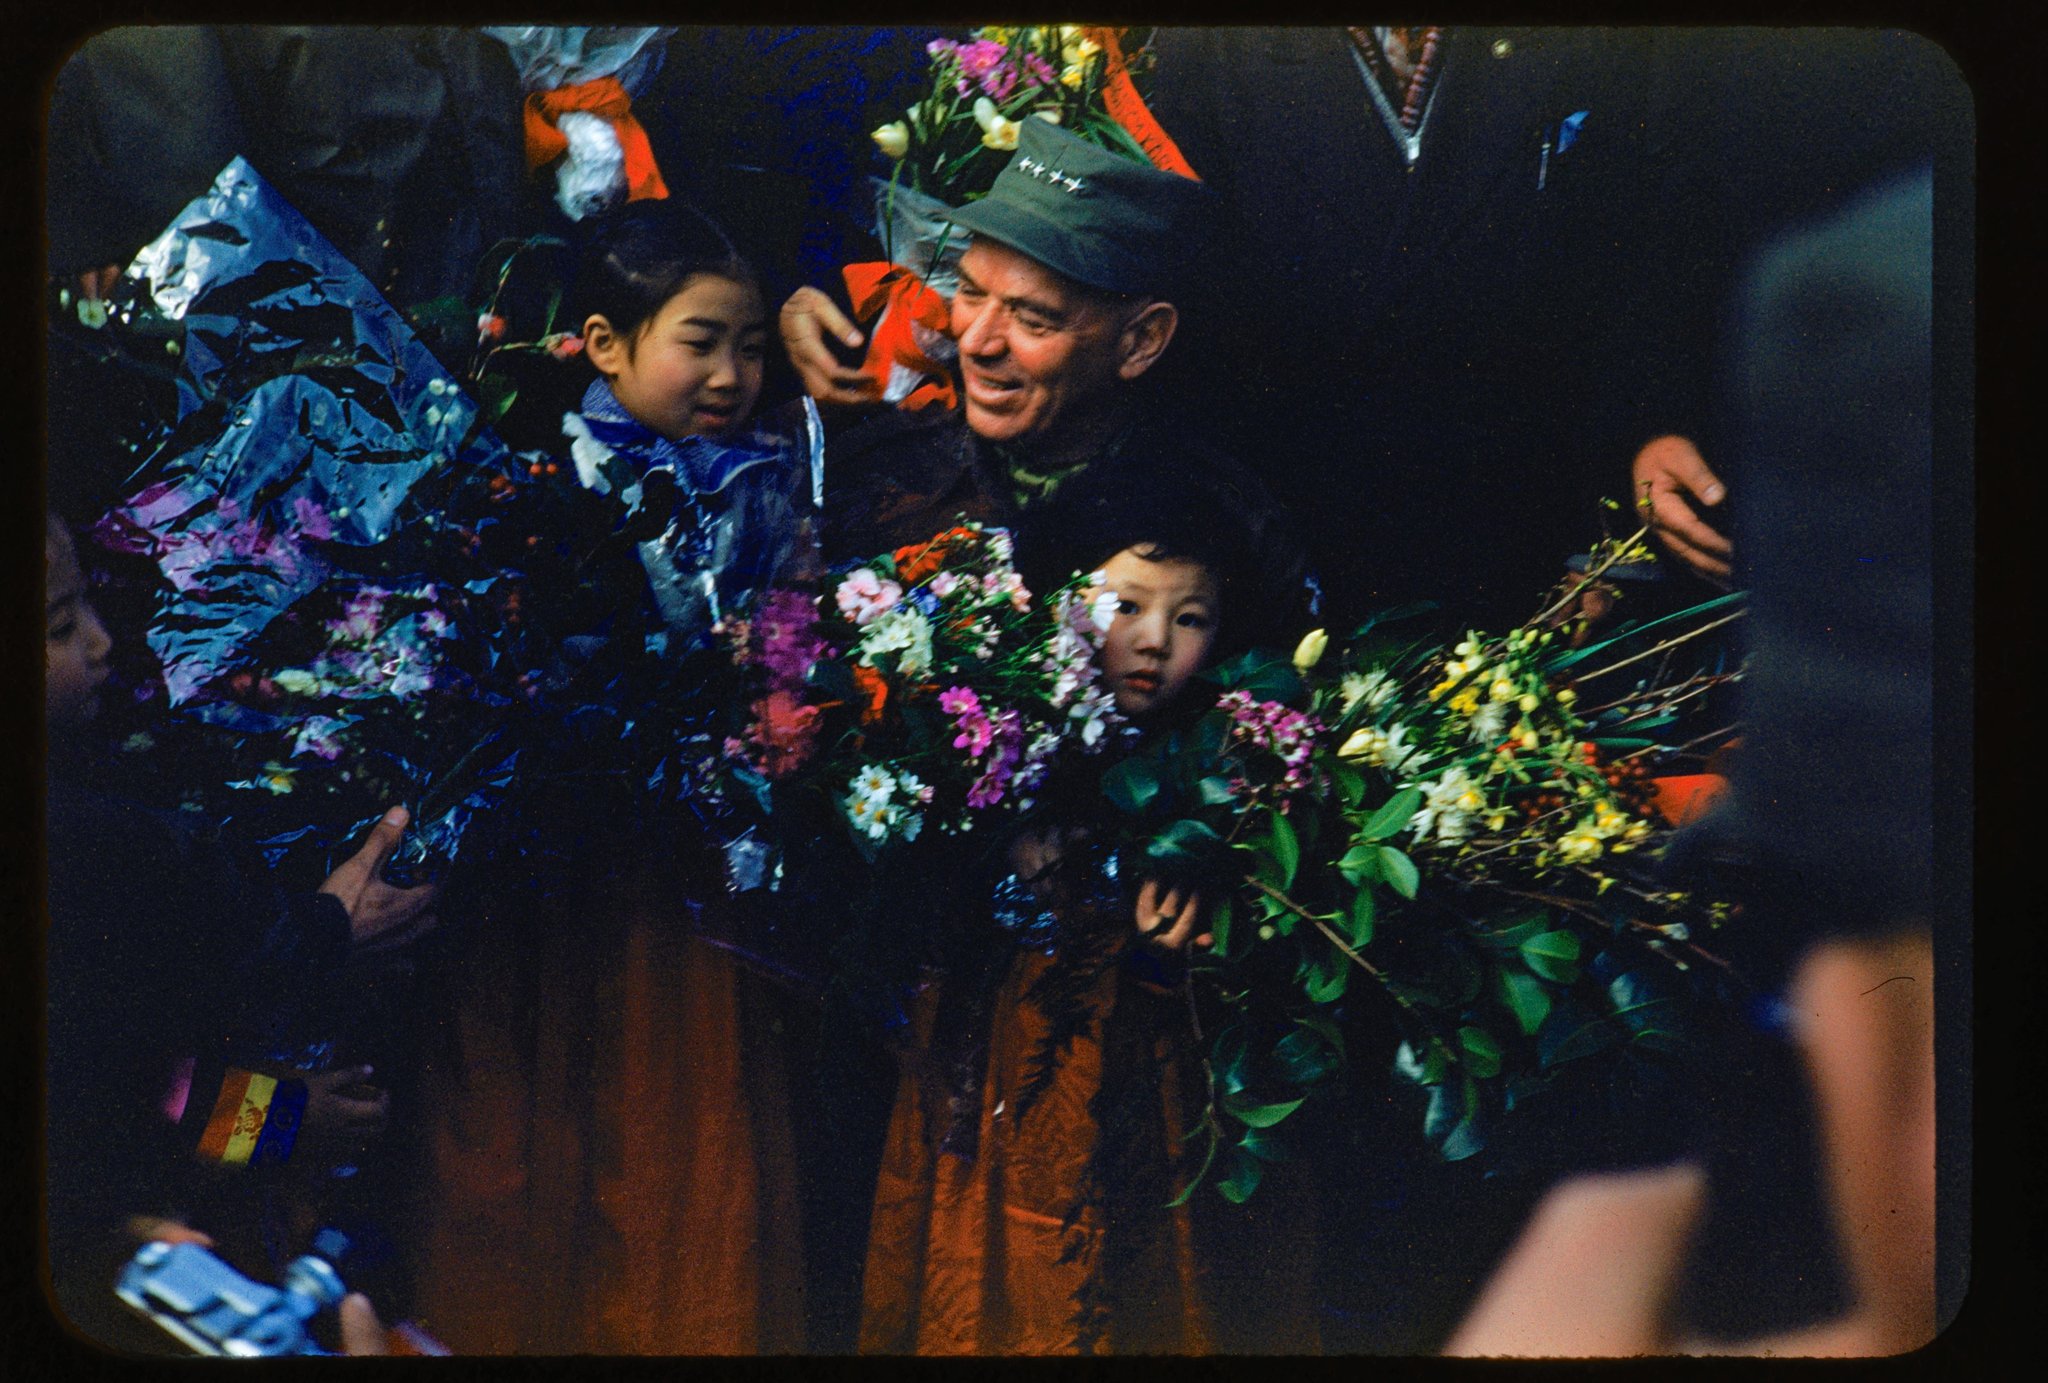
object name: color slide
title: Oorlog in Korea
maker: david ketel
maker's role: diplomaat, sinoloog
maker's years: 1913-2008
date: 1951-1953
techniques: slide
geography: korea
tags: united nations